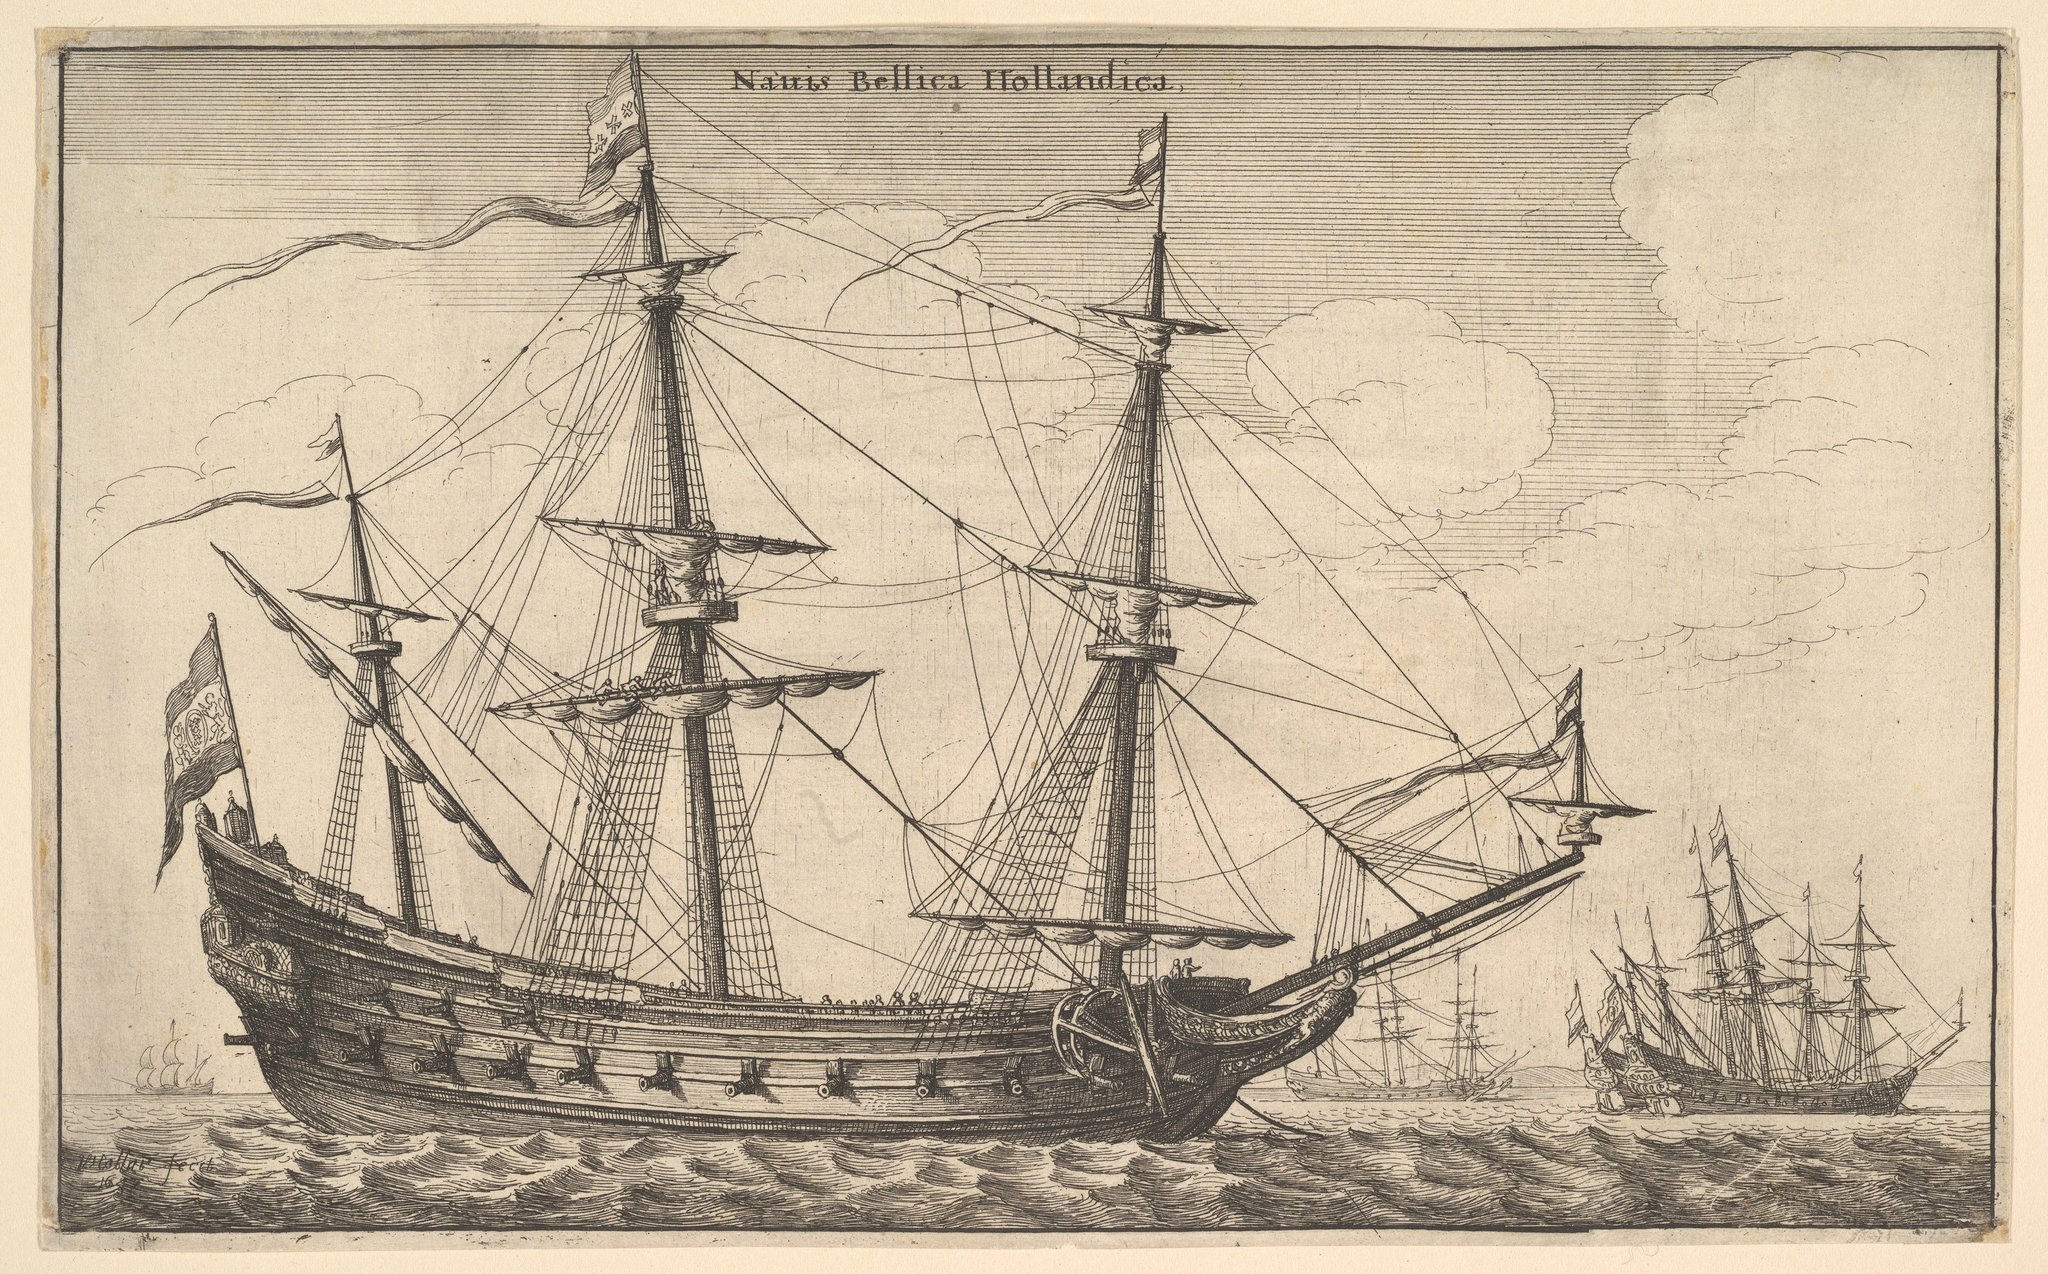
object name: print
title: Dutch Warship (Nauis Bellica Hollandica)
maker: wenceslaus hollar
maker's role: artist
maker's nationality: bohemian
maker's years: 1607-1677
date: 1647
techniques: etching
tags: ships